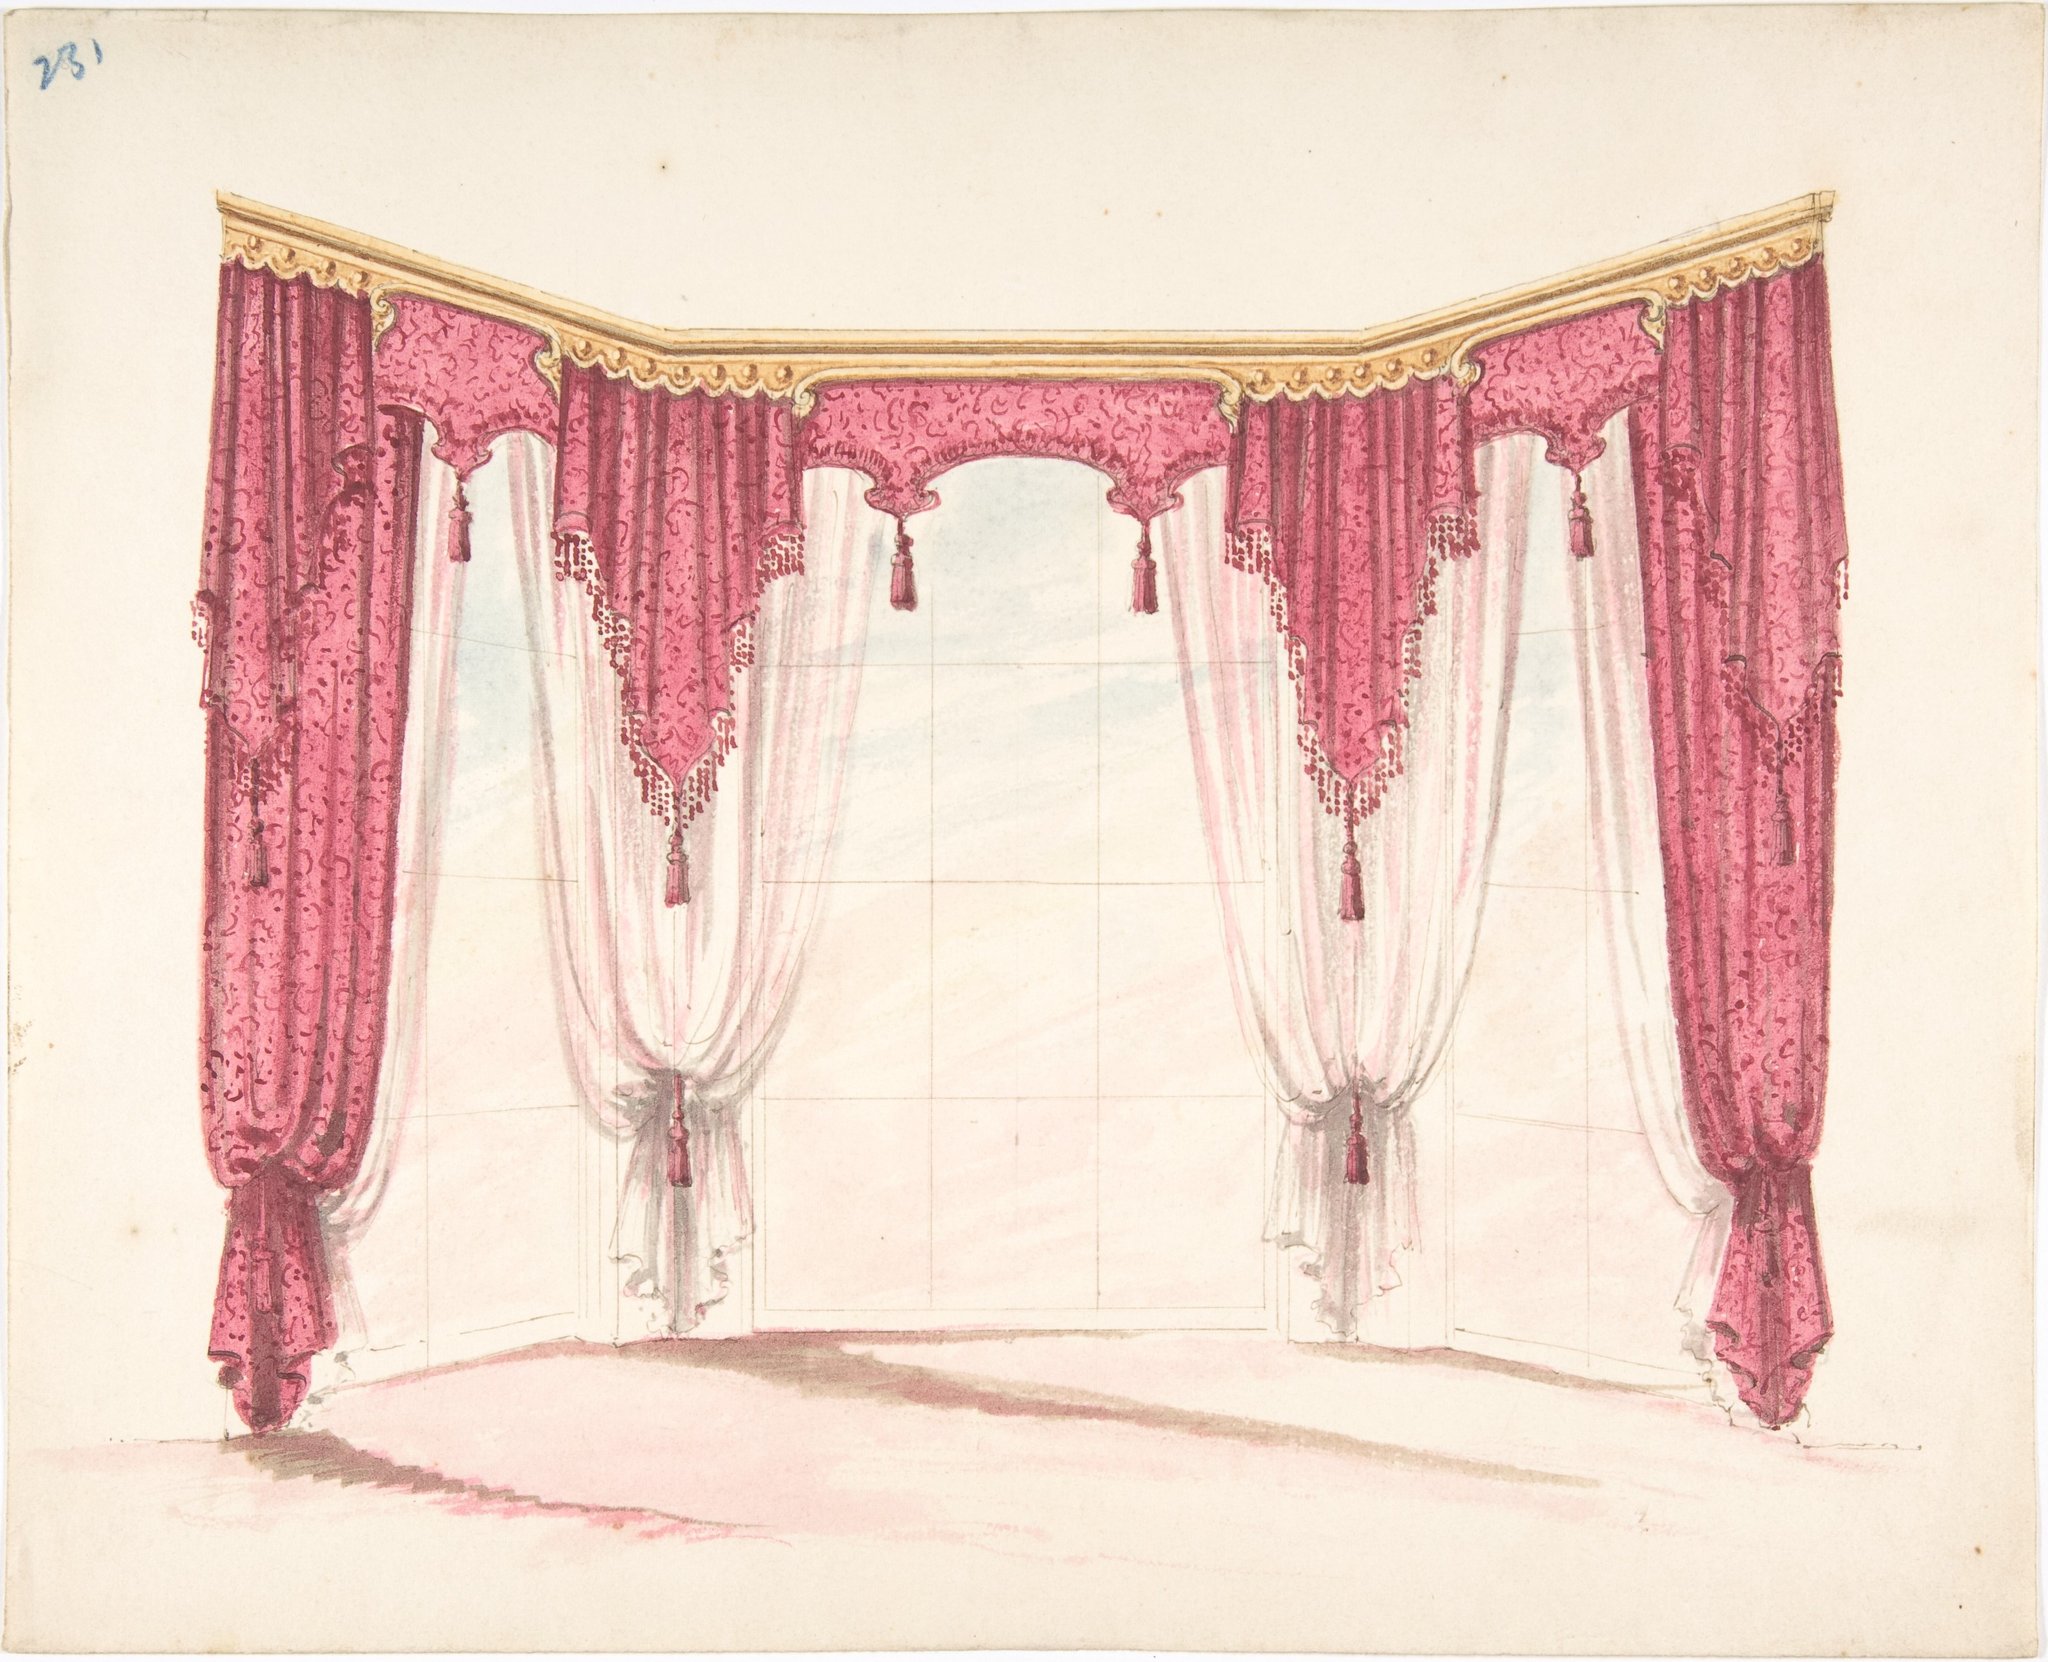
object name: drawing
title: Design for Red Curtains with Red Fringes and a Gold Pediment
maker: anonymous, british, 19th century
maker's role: artist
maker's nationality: british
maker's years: 1800-1900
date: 1801-1833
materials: ink, watercolor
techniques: brush, pen, wash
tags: curtains